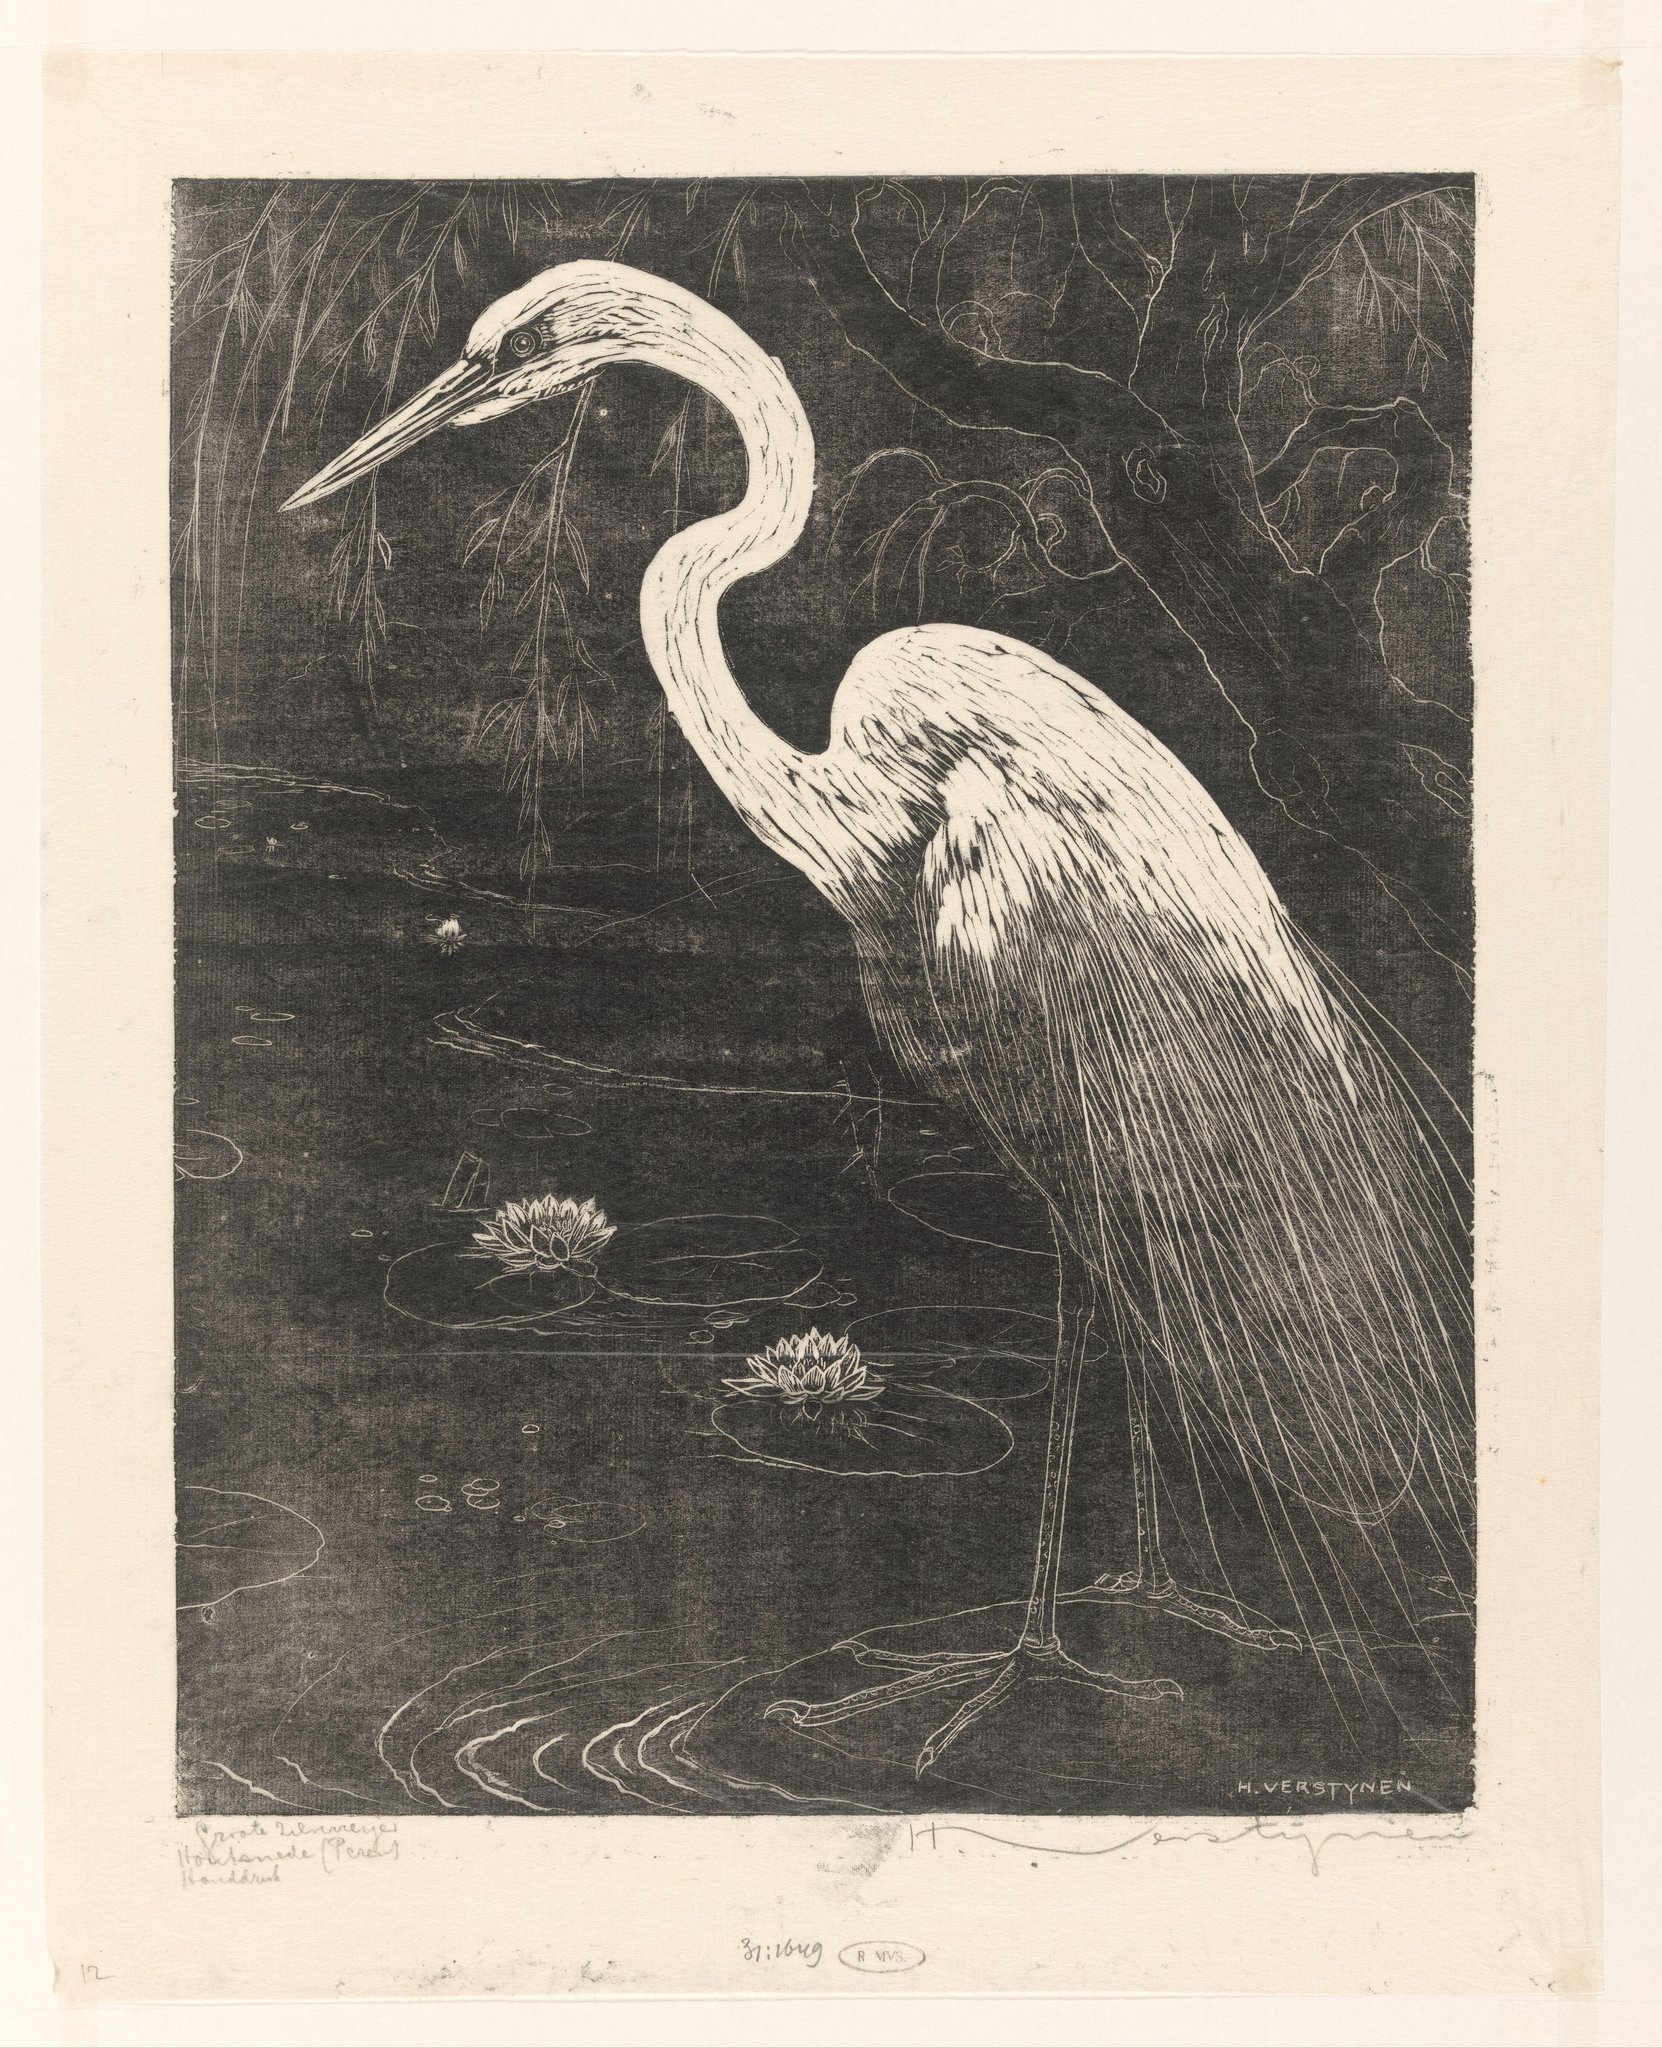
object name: print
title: Groote zilverreiger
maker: henri verstijnen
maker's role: draughtsman, print maker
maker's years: 1882-1940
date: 1921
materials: paper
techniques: woodcut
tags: shore-birds and wading-birds: heron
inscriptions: collector's mark: Lugt 2228, annotation: ‘Houtsnede (peren)’